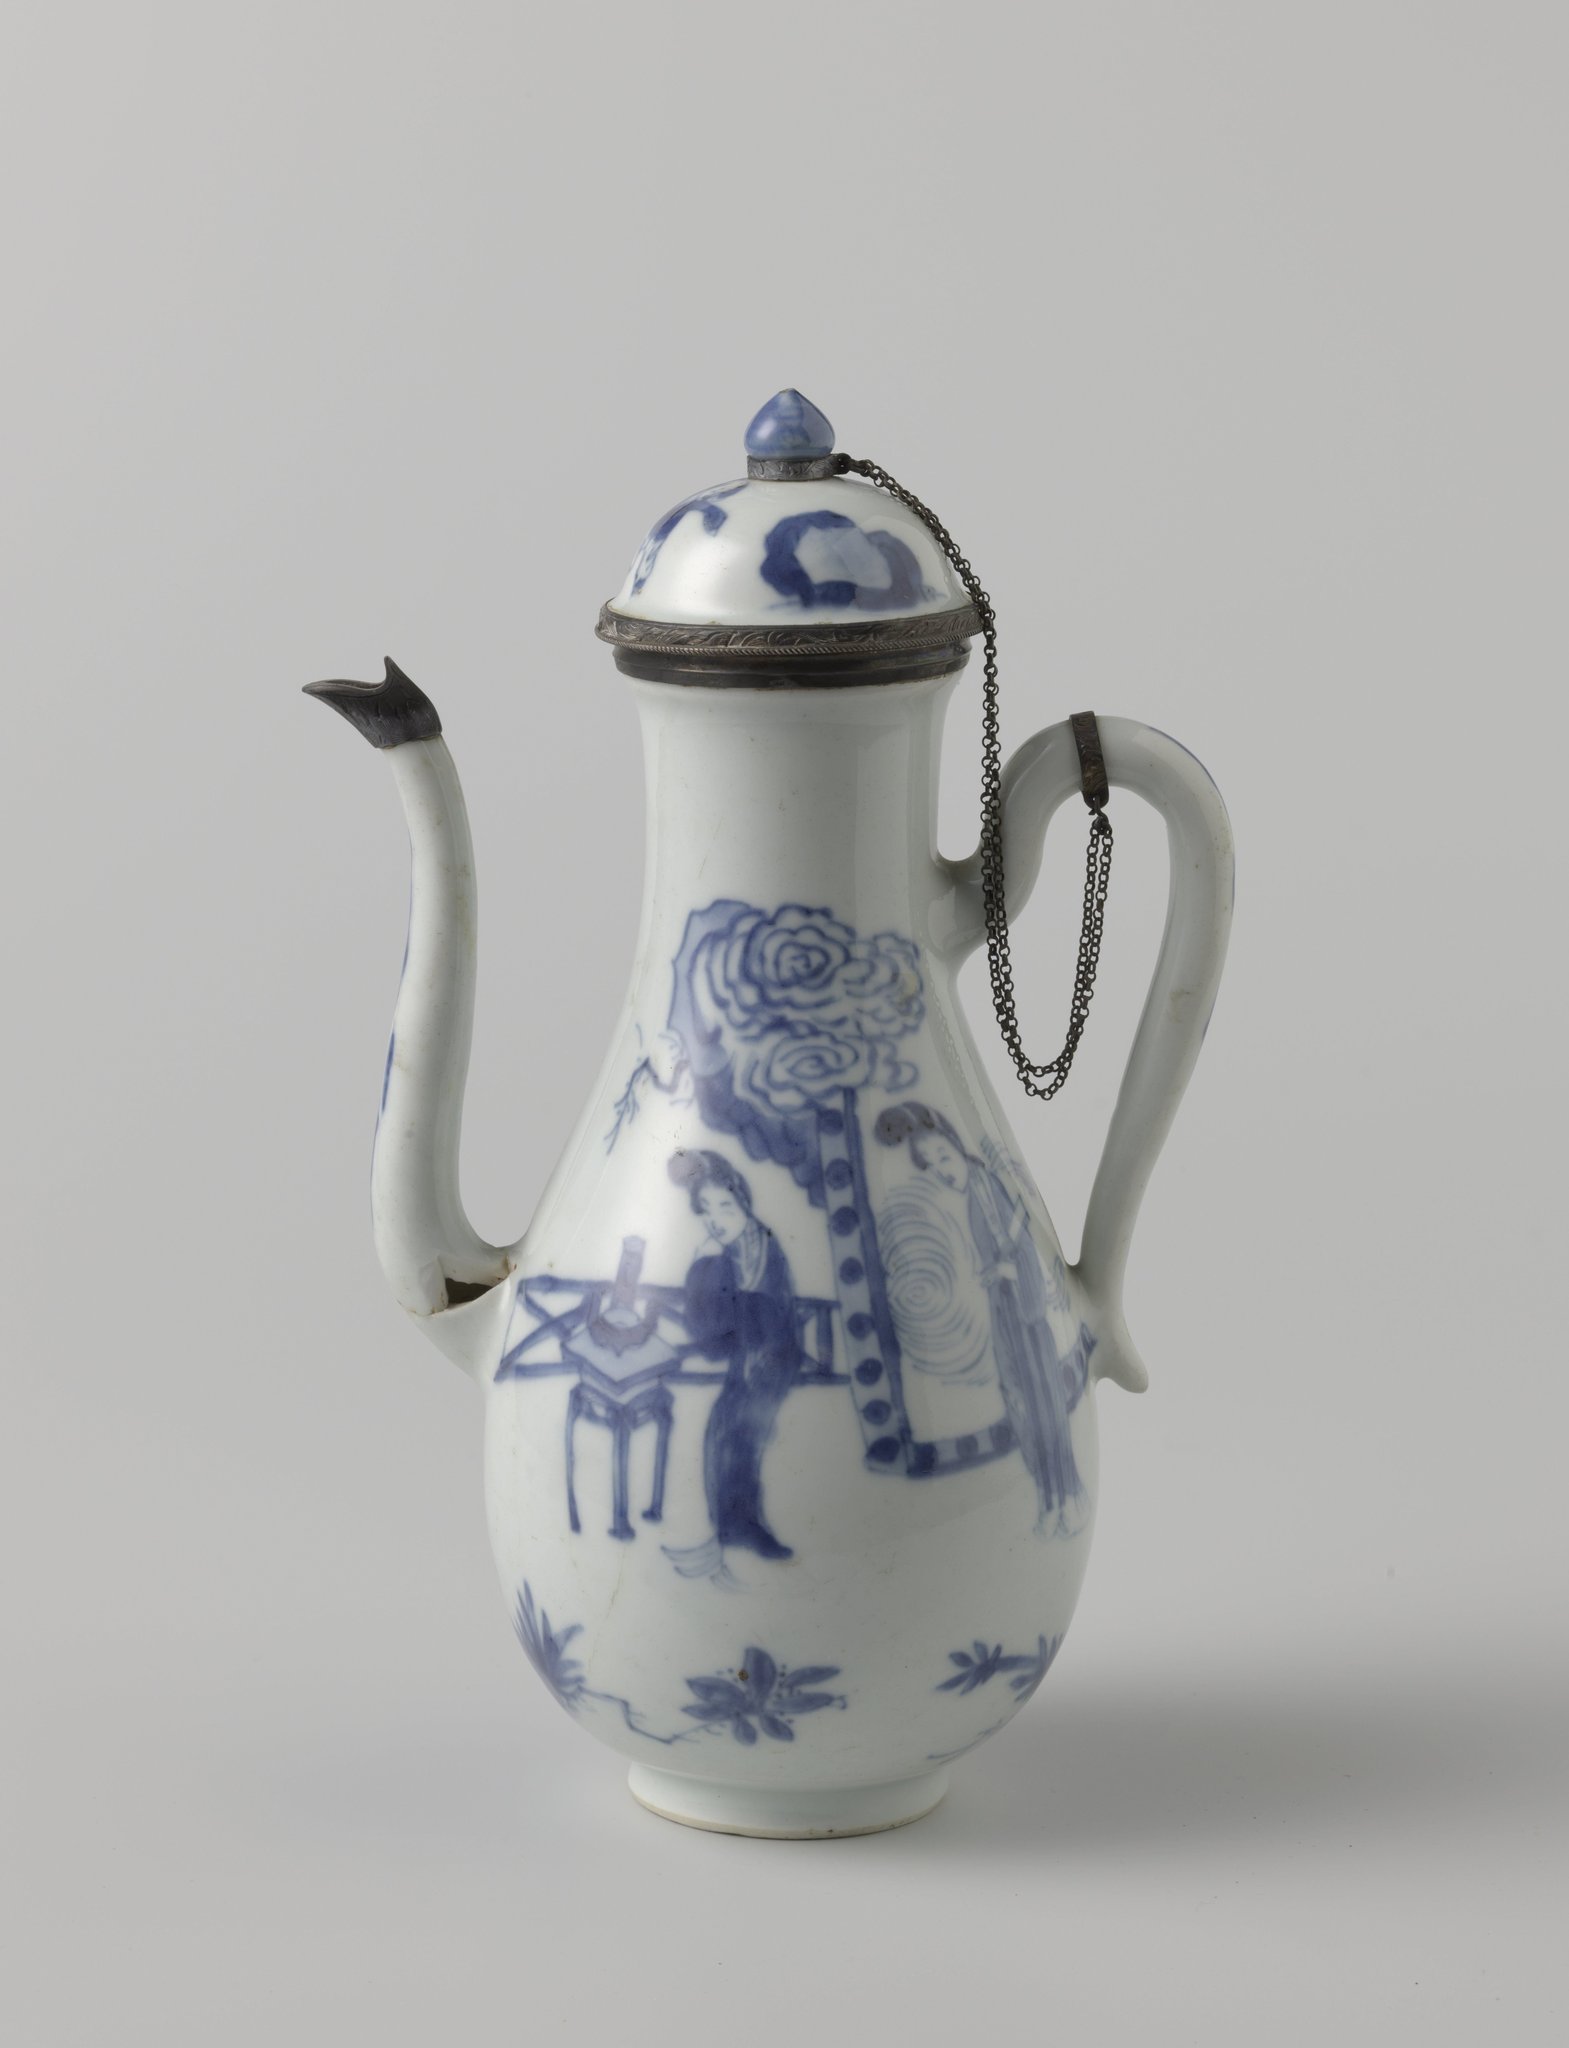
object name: milk jug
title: Pear-shaped milk jug with women and boys, silver mounts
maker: Anonymous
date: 1675-1699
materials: cobalt, glaze, paint, porcelain, silver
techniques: casting, firing, turning, vitrification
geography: china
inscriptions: mark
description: Peervormige melkkan van porselein met oor, gebogen tuit en zilveren montuur, beschilderd in onderglazuur blauw. Op de wand tweemaal twee vrouwen (lange lijzen) in een omheinde tuin, waaronder tweemaal een rots met bloemen; de deksel met twee dansende jongens (zotjes) met twee rotsen. Gemerkt op de onderzijde met een artimisiablad. Barst in de wand van de kan, tuit is gebroken geweest. Blauw-wit.